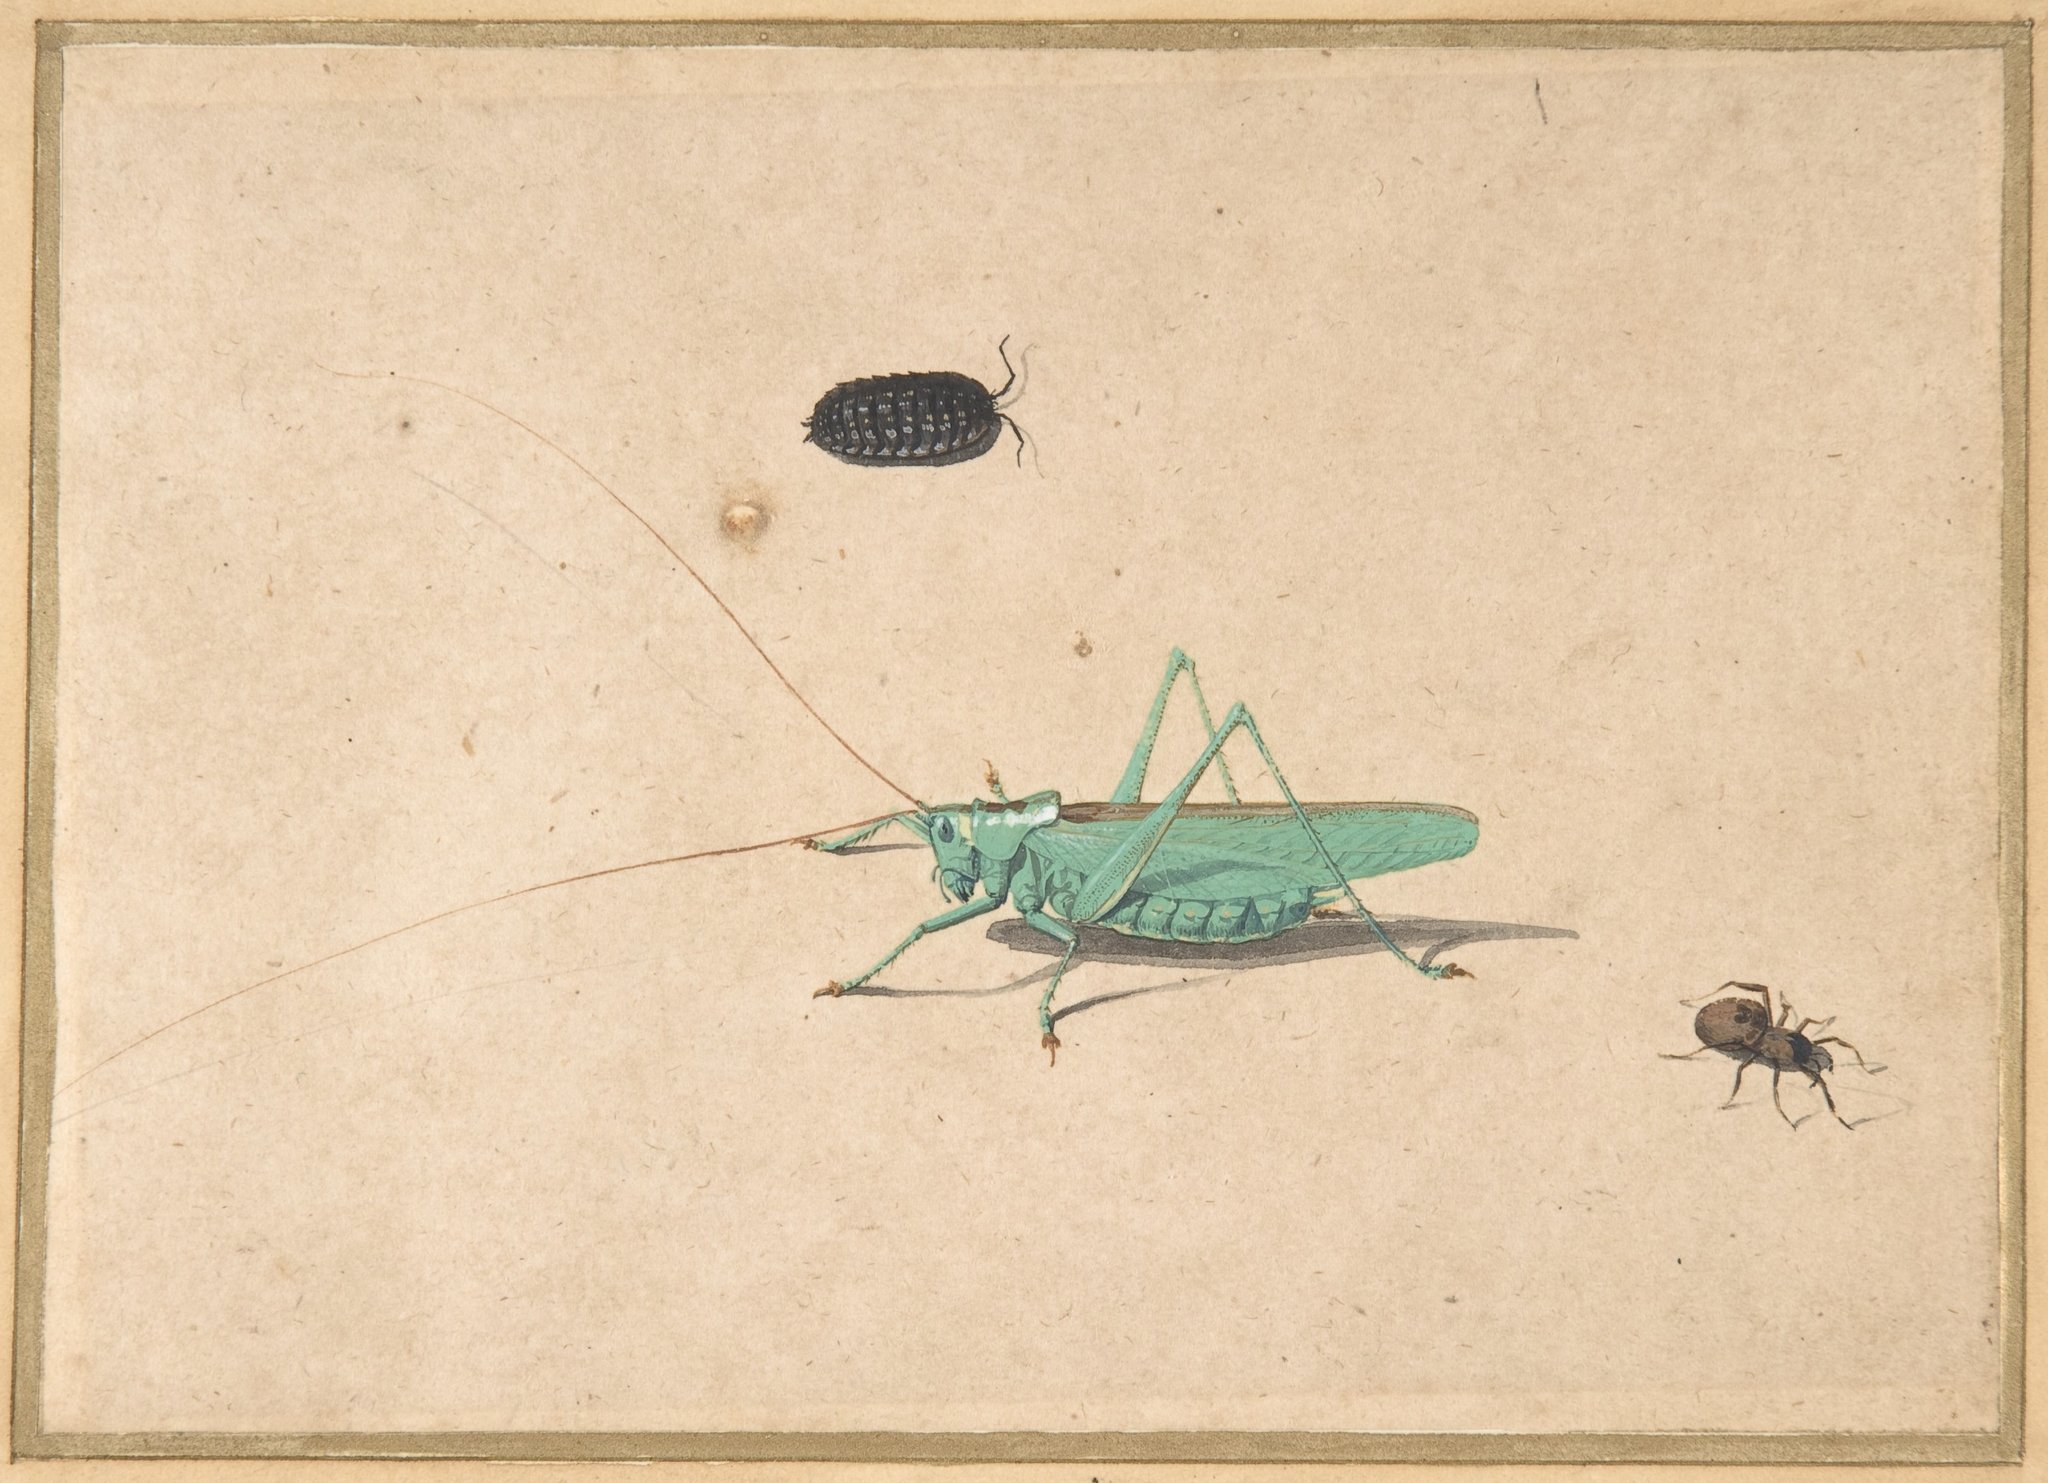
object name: drawing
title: A Great Green Bush Cricket (Tettigorica viridissima Linneaeus), A Clioniona Spider, and a Beetle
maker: anonymous, dutch, 17th century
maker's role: artist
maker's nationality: dutch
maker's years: 1600-1700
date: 1601-1700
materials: gouache, ink, watercolor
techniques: pen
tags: insects